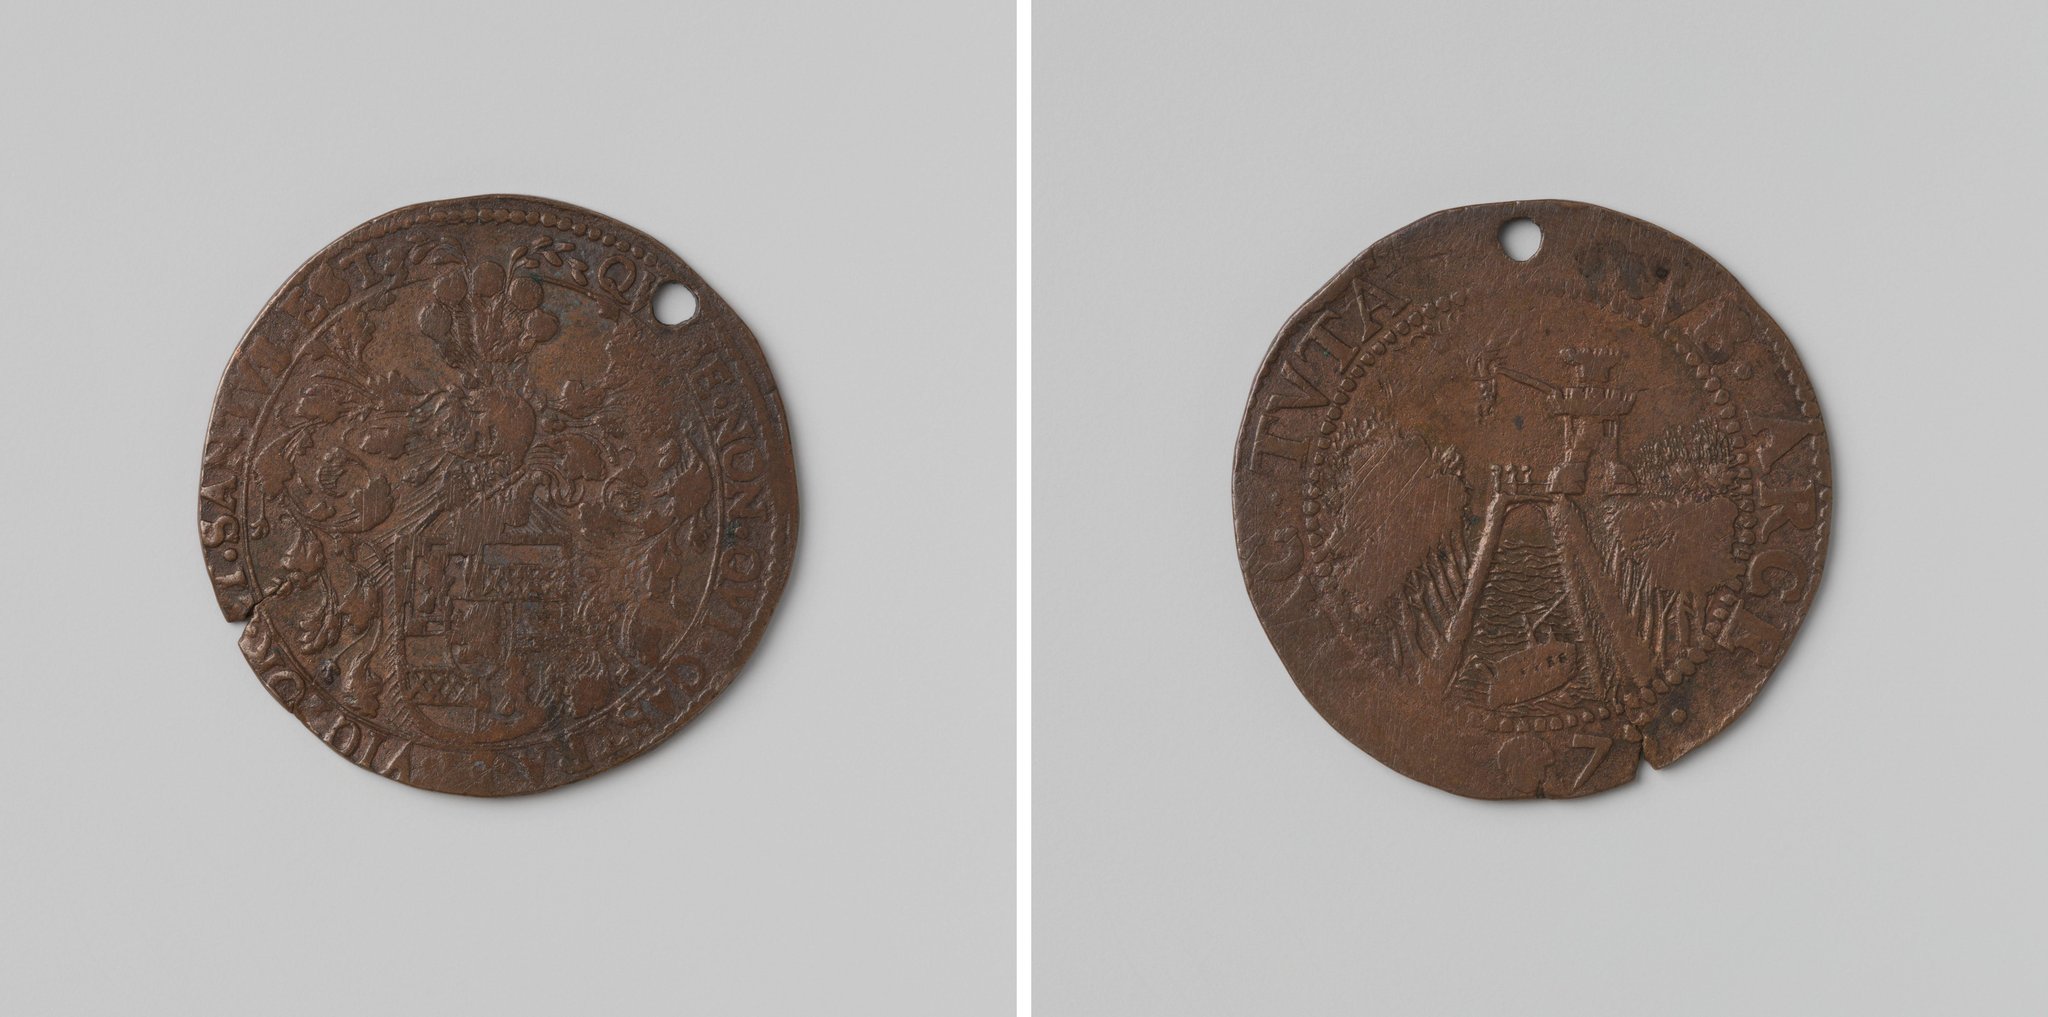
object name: jeton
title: Ferdinand de Saint-Victor, zevenenveertigste intendant van de vaart van Brussel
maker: Anonymous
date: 1675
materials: copper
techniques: striking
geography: brussels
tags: ferdinand de saint-victor, willebroekse vaart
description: Koperen penning met gat erin. Voorzijde: gehelmd wapenschild. Keerzijde: schip op kanaal, aan weerszijden geflankeerd door rij bomen; op achtergrond: toren binnen omschrift